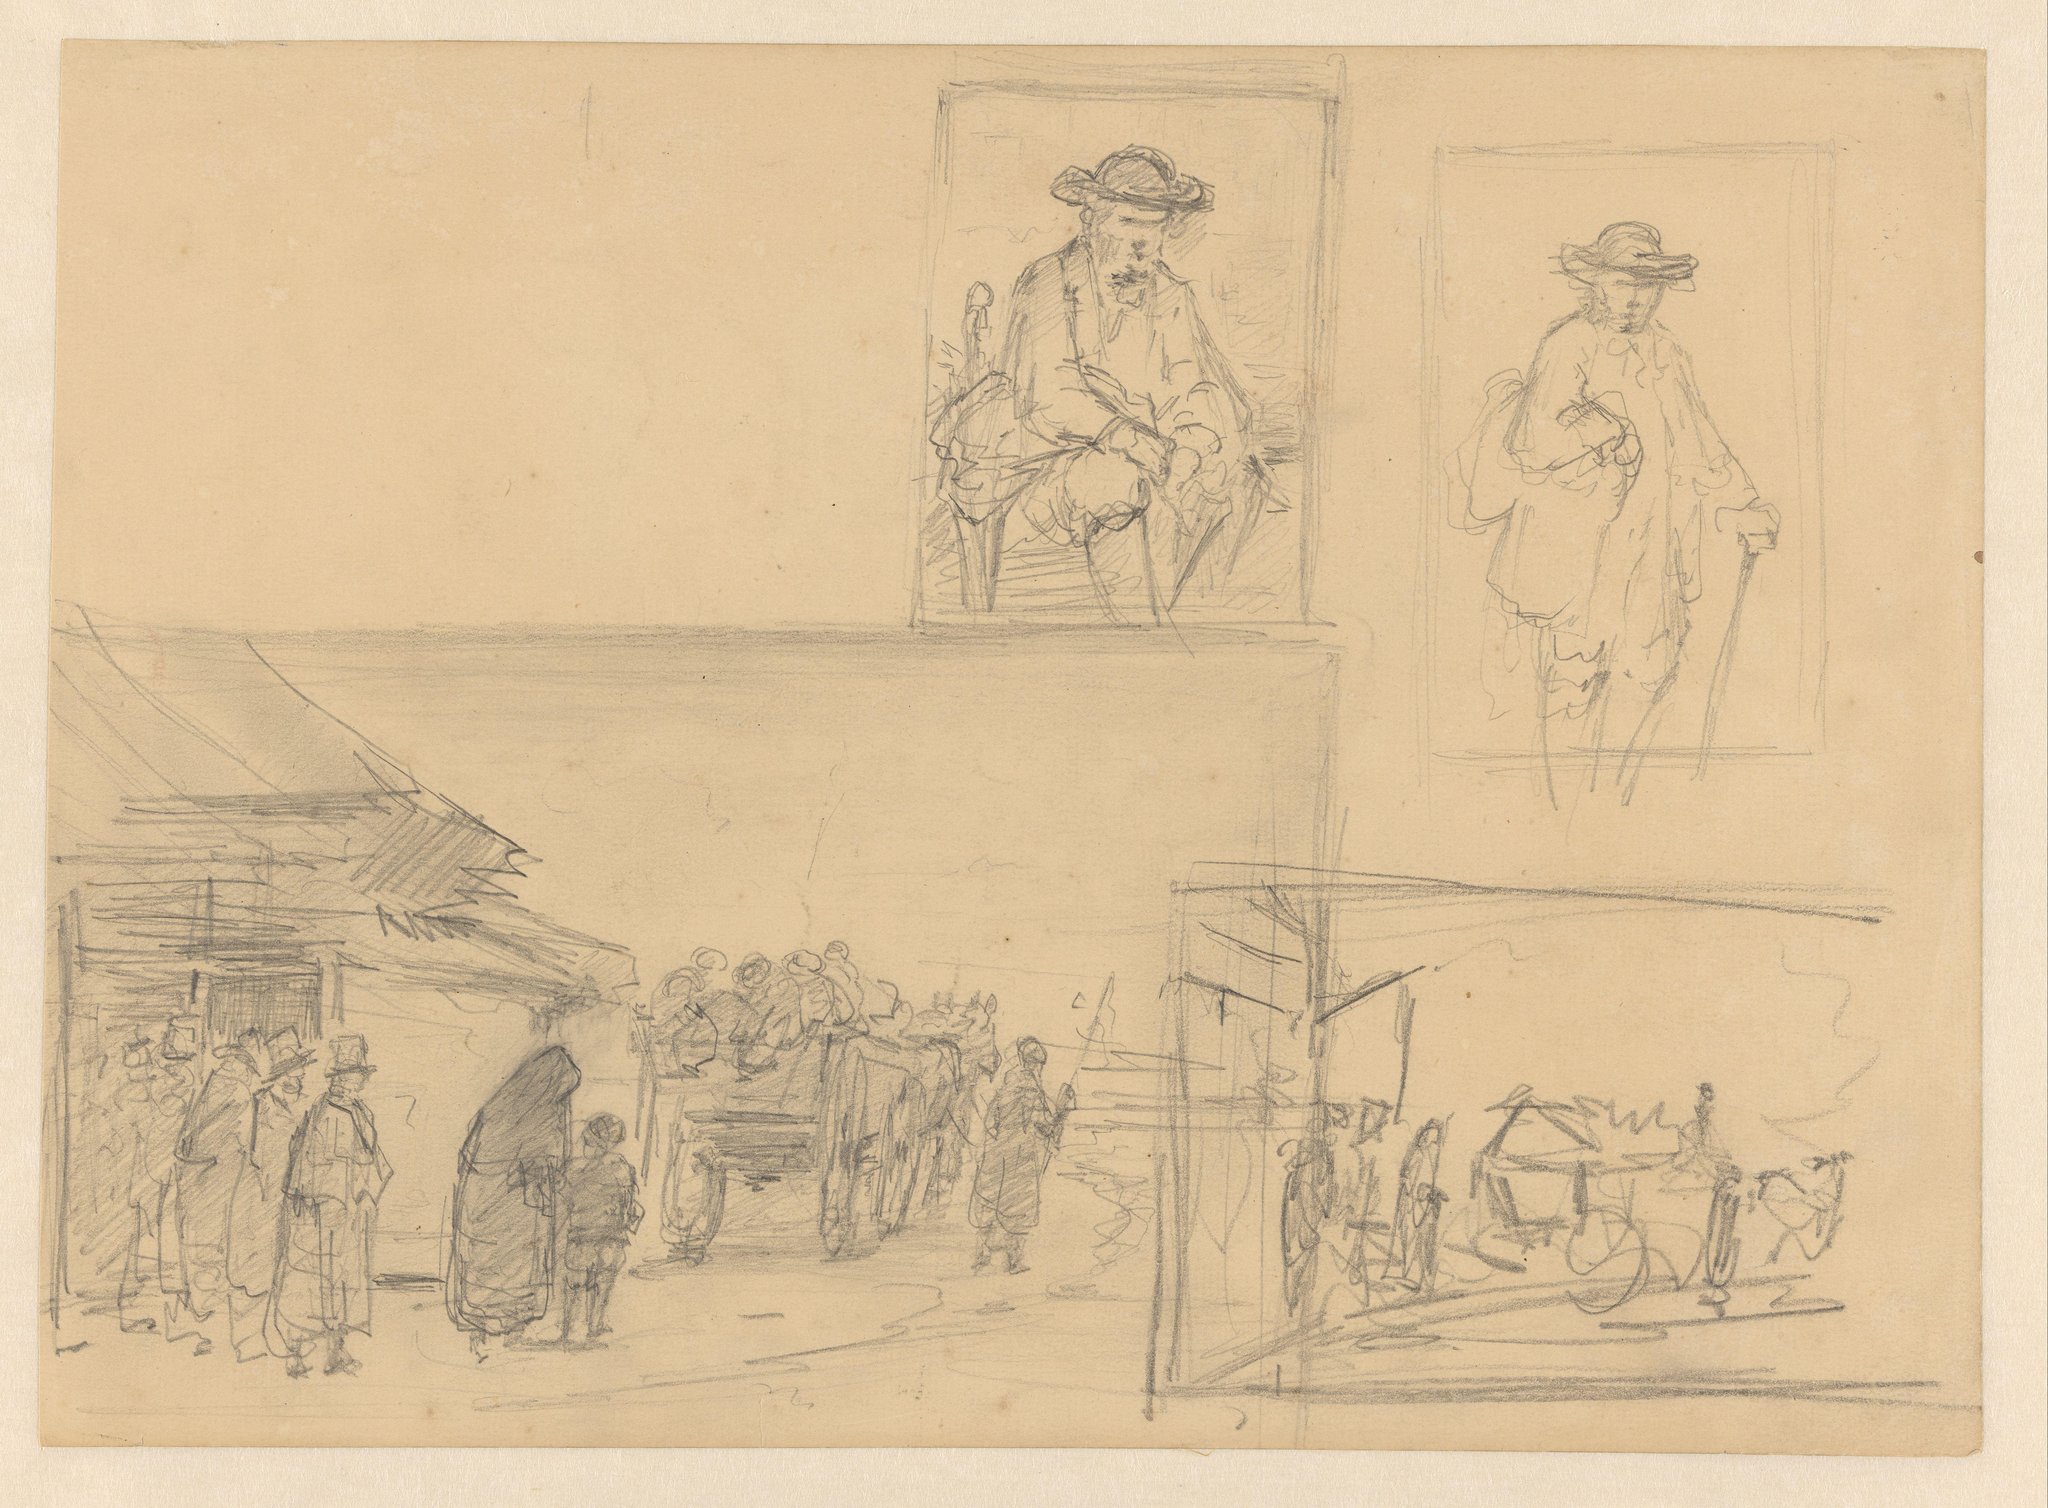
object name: drawing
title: Twee schetsen van een begrafenisstoet en twee schetsen van een man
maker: hendrik valkenburg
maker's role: draughtsman, painter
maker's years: 1826-1896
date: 1836-1896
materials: chalk, paper, pencil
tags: cortege, funeral procession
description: Twee schetsen van een begrafenisstoet bij een boerenwoning; twee schetsen van een man met breedgerande hoed. Verso: begrafenisstoet verlaat een woning.